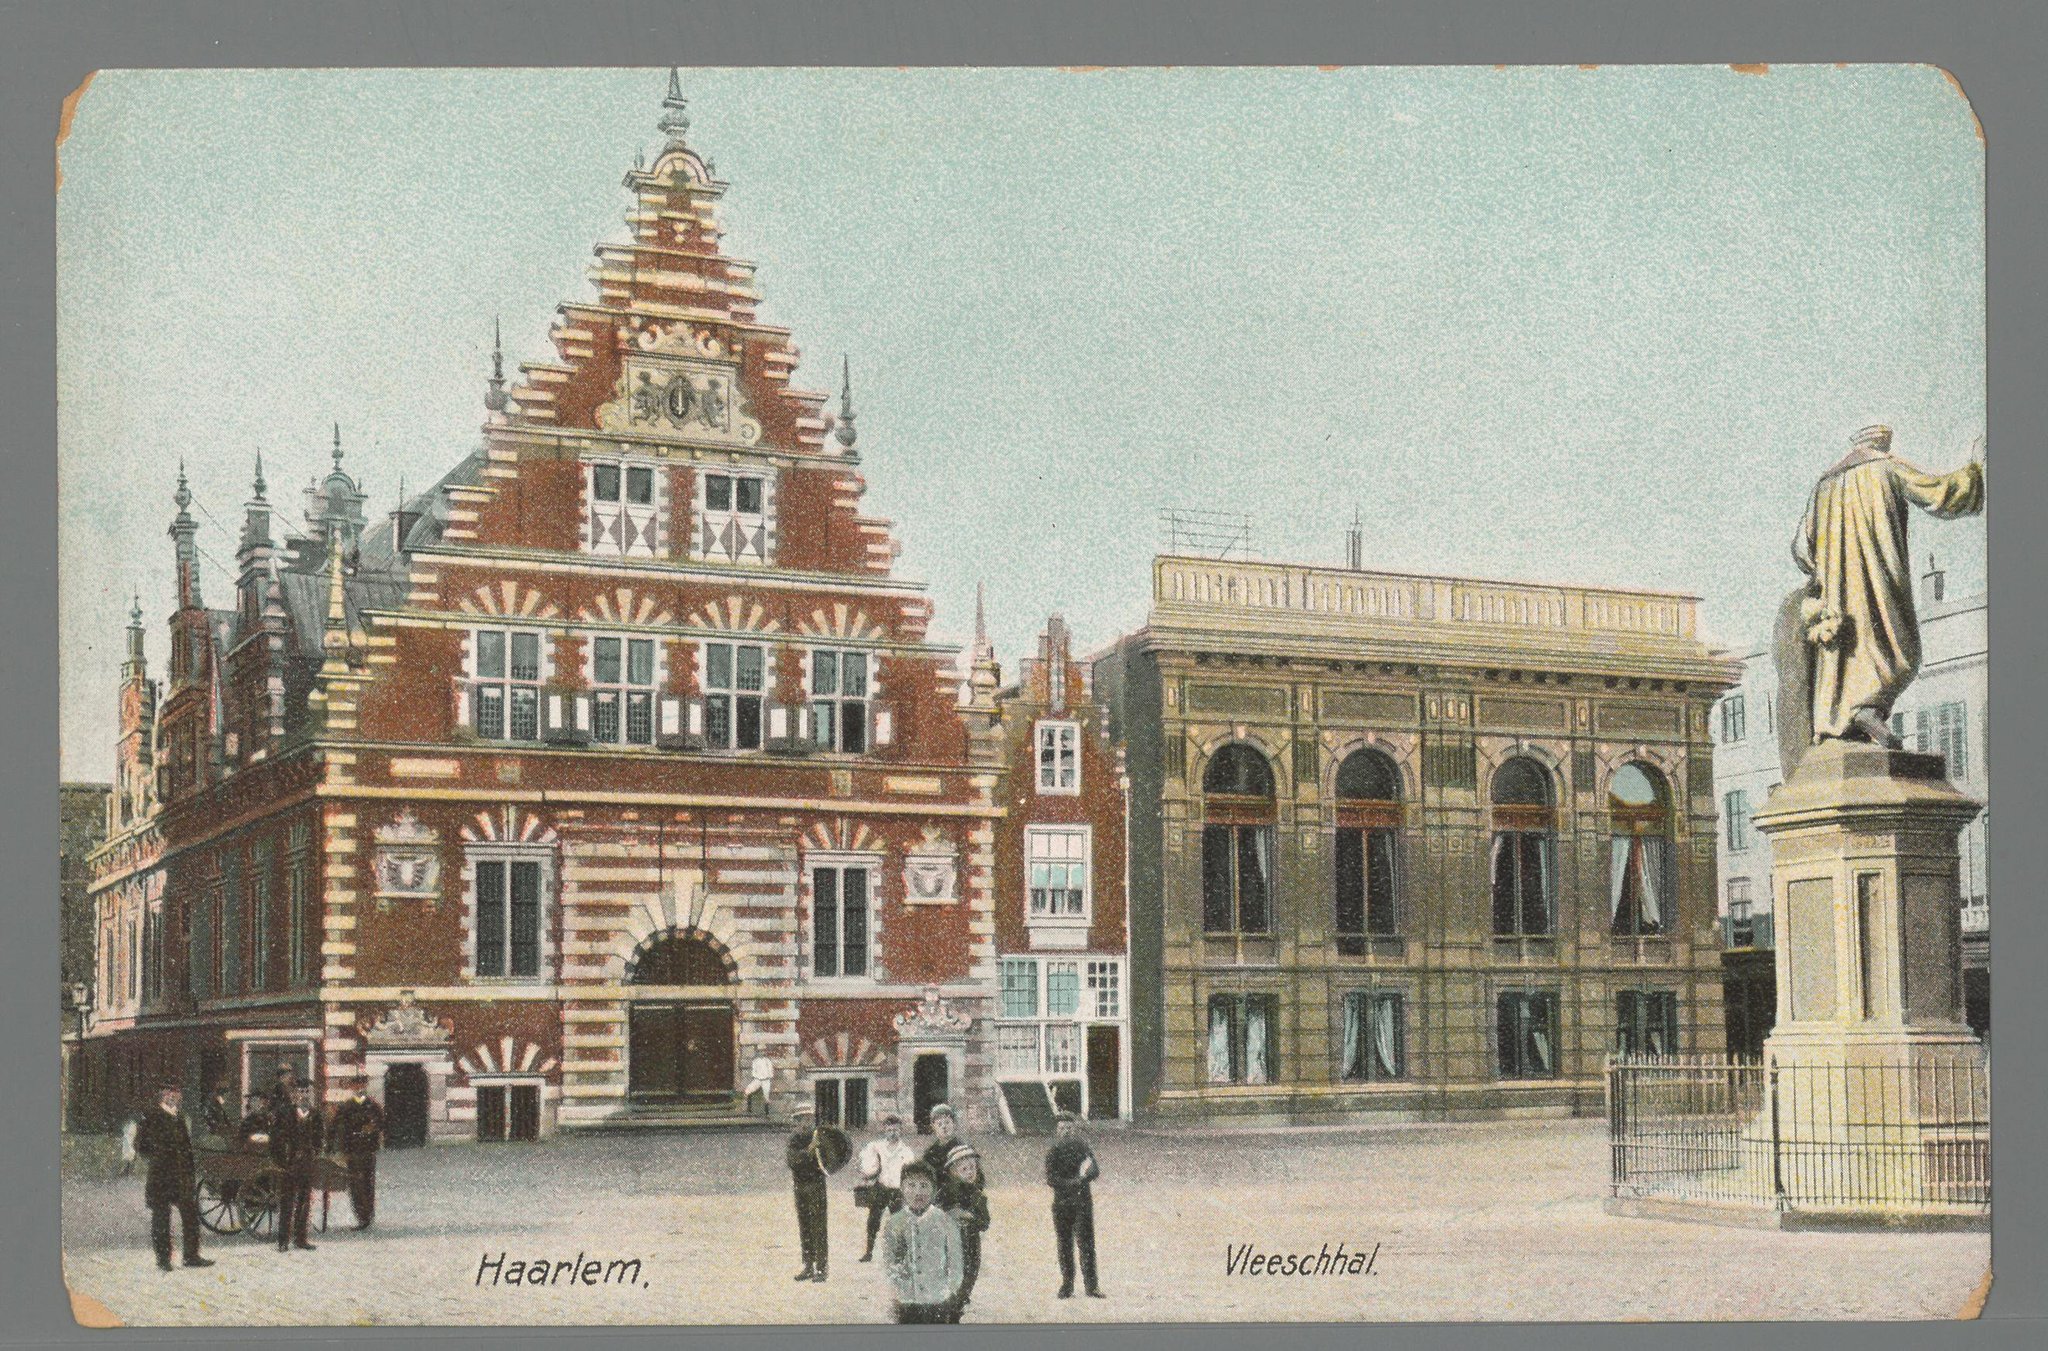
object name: photomechanical print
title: Haarlem. Vleeschhal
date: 1905-1906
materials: cardboard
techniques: lithograph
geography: amsterdam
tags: haarlem, city-view, and landscape with man-made constructions, monument, statue, market